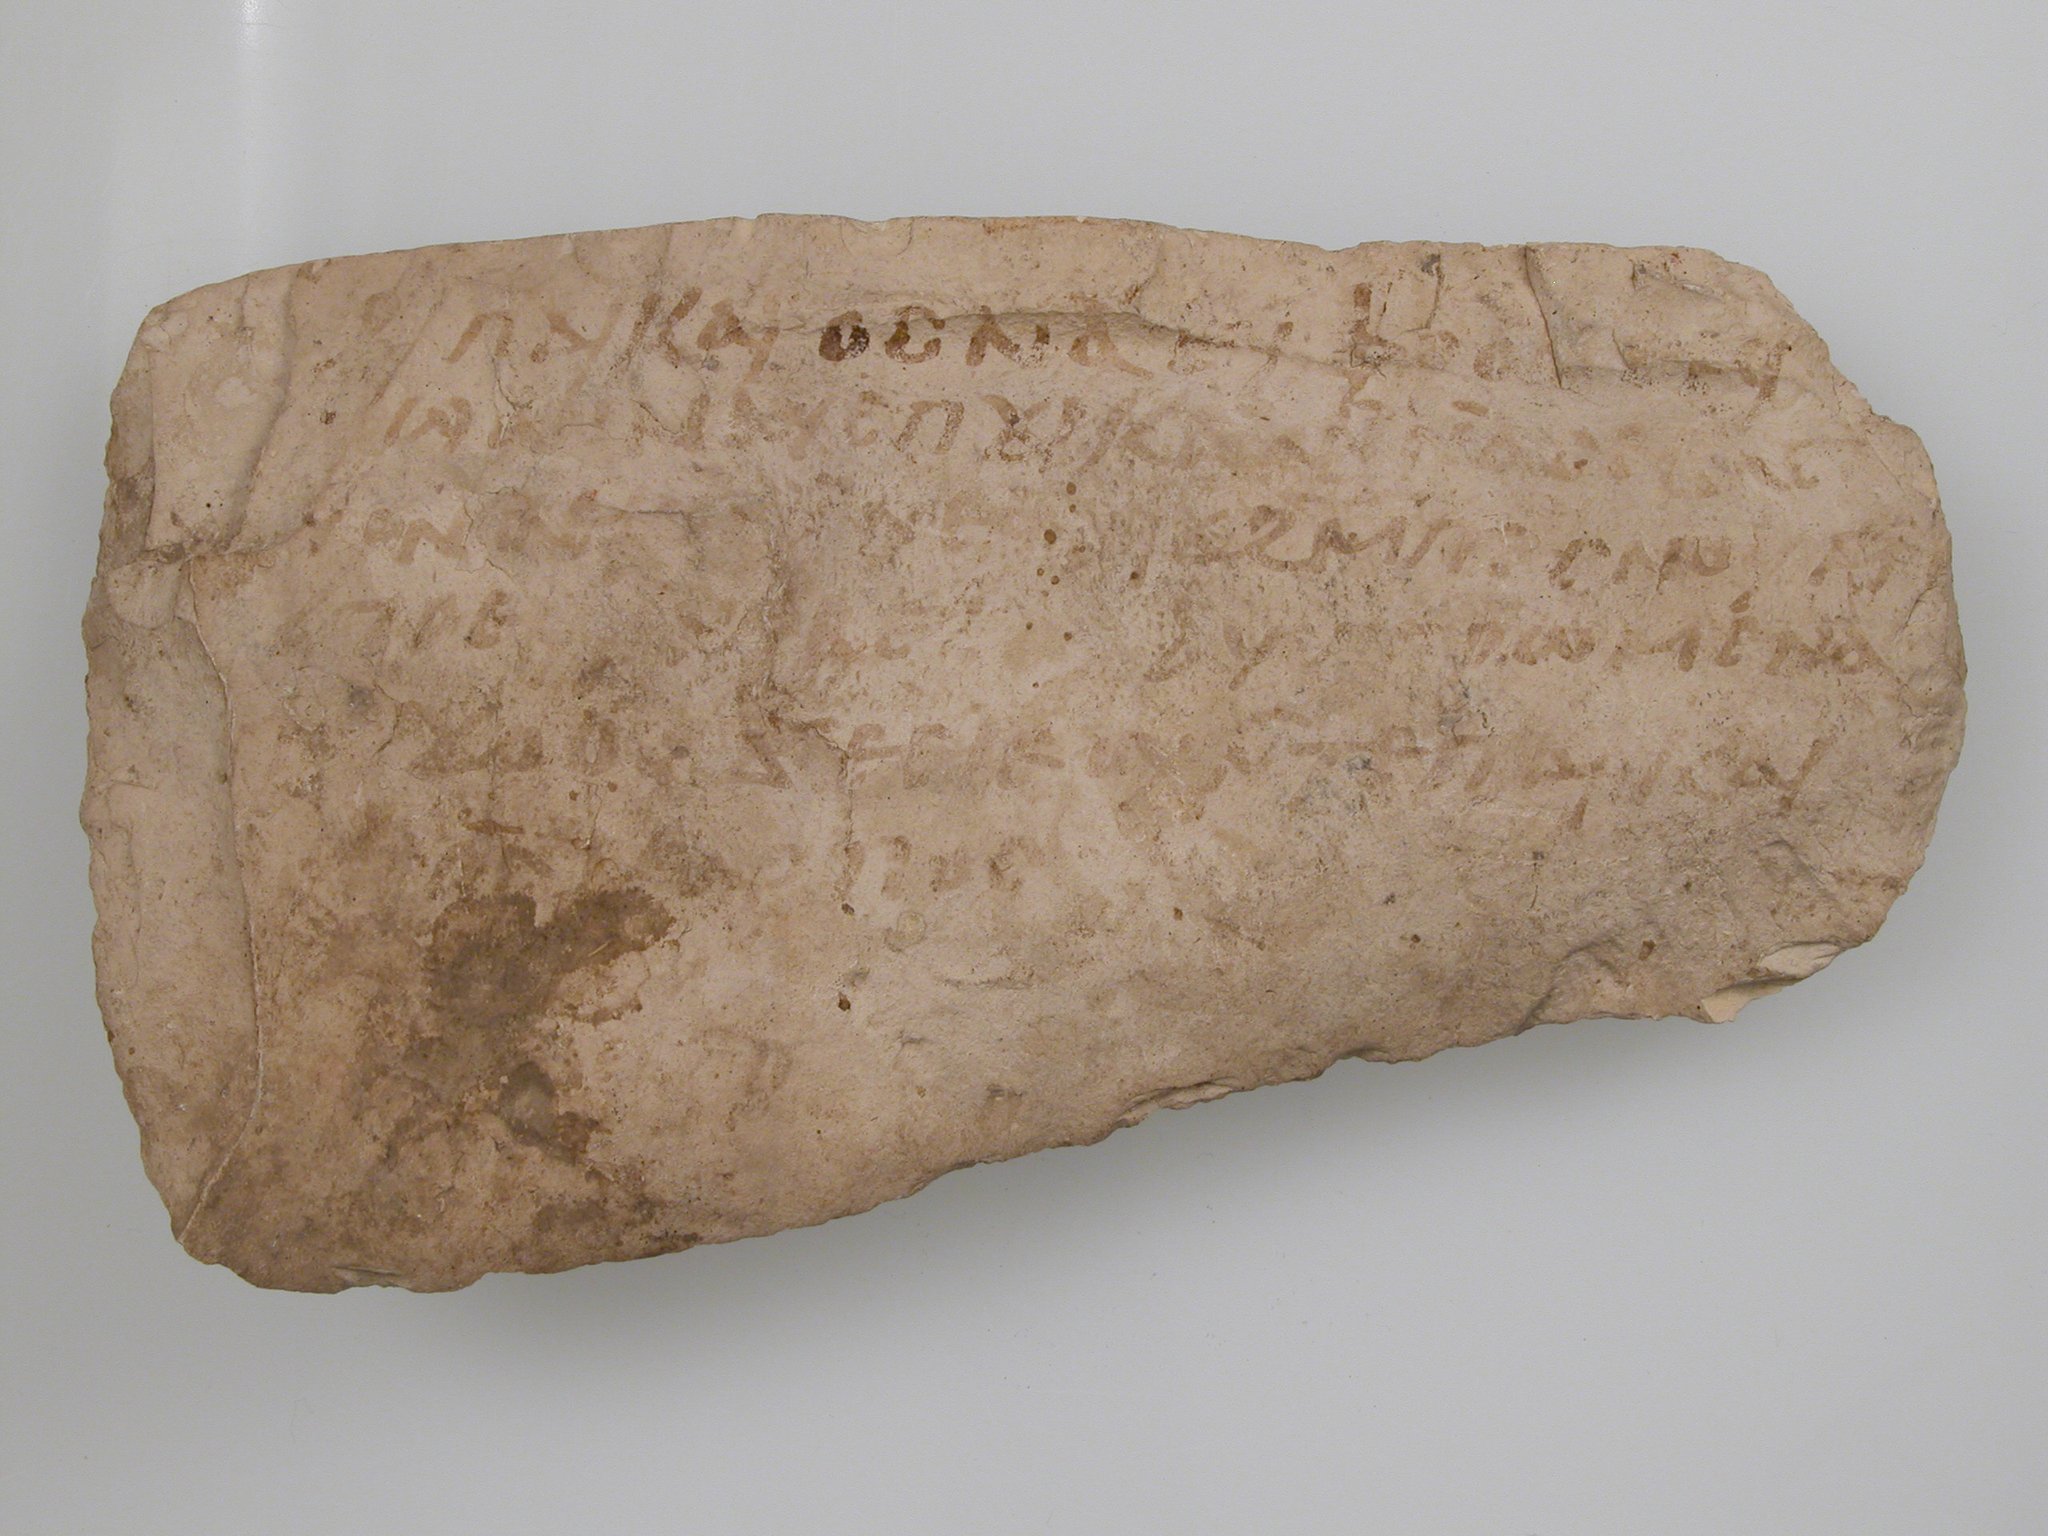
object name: ostrakon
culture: coptic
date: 600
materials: ink, pottery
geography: egypt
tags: coptic,documents